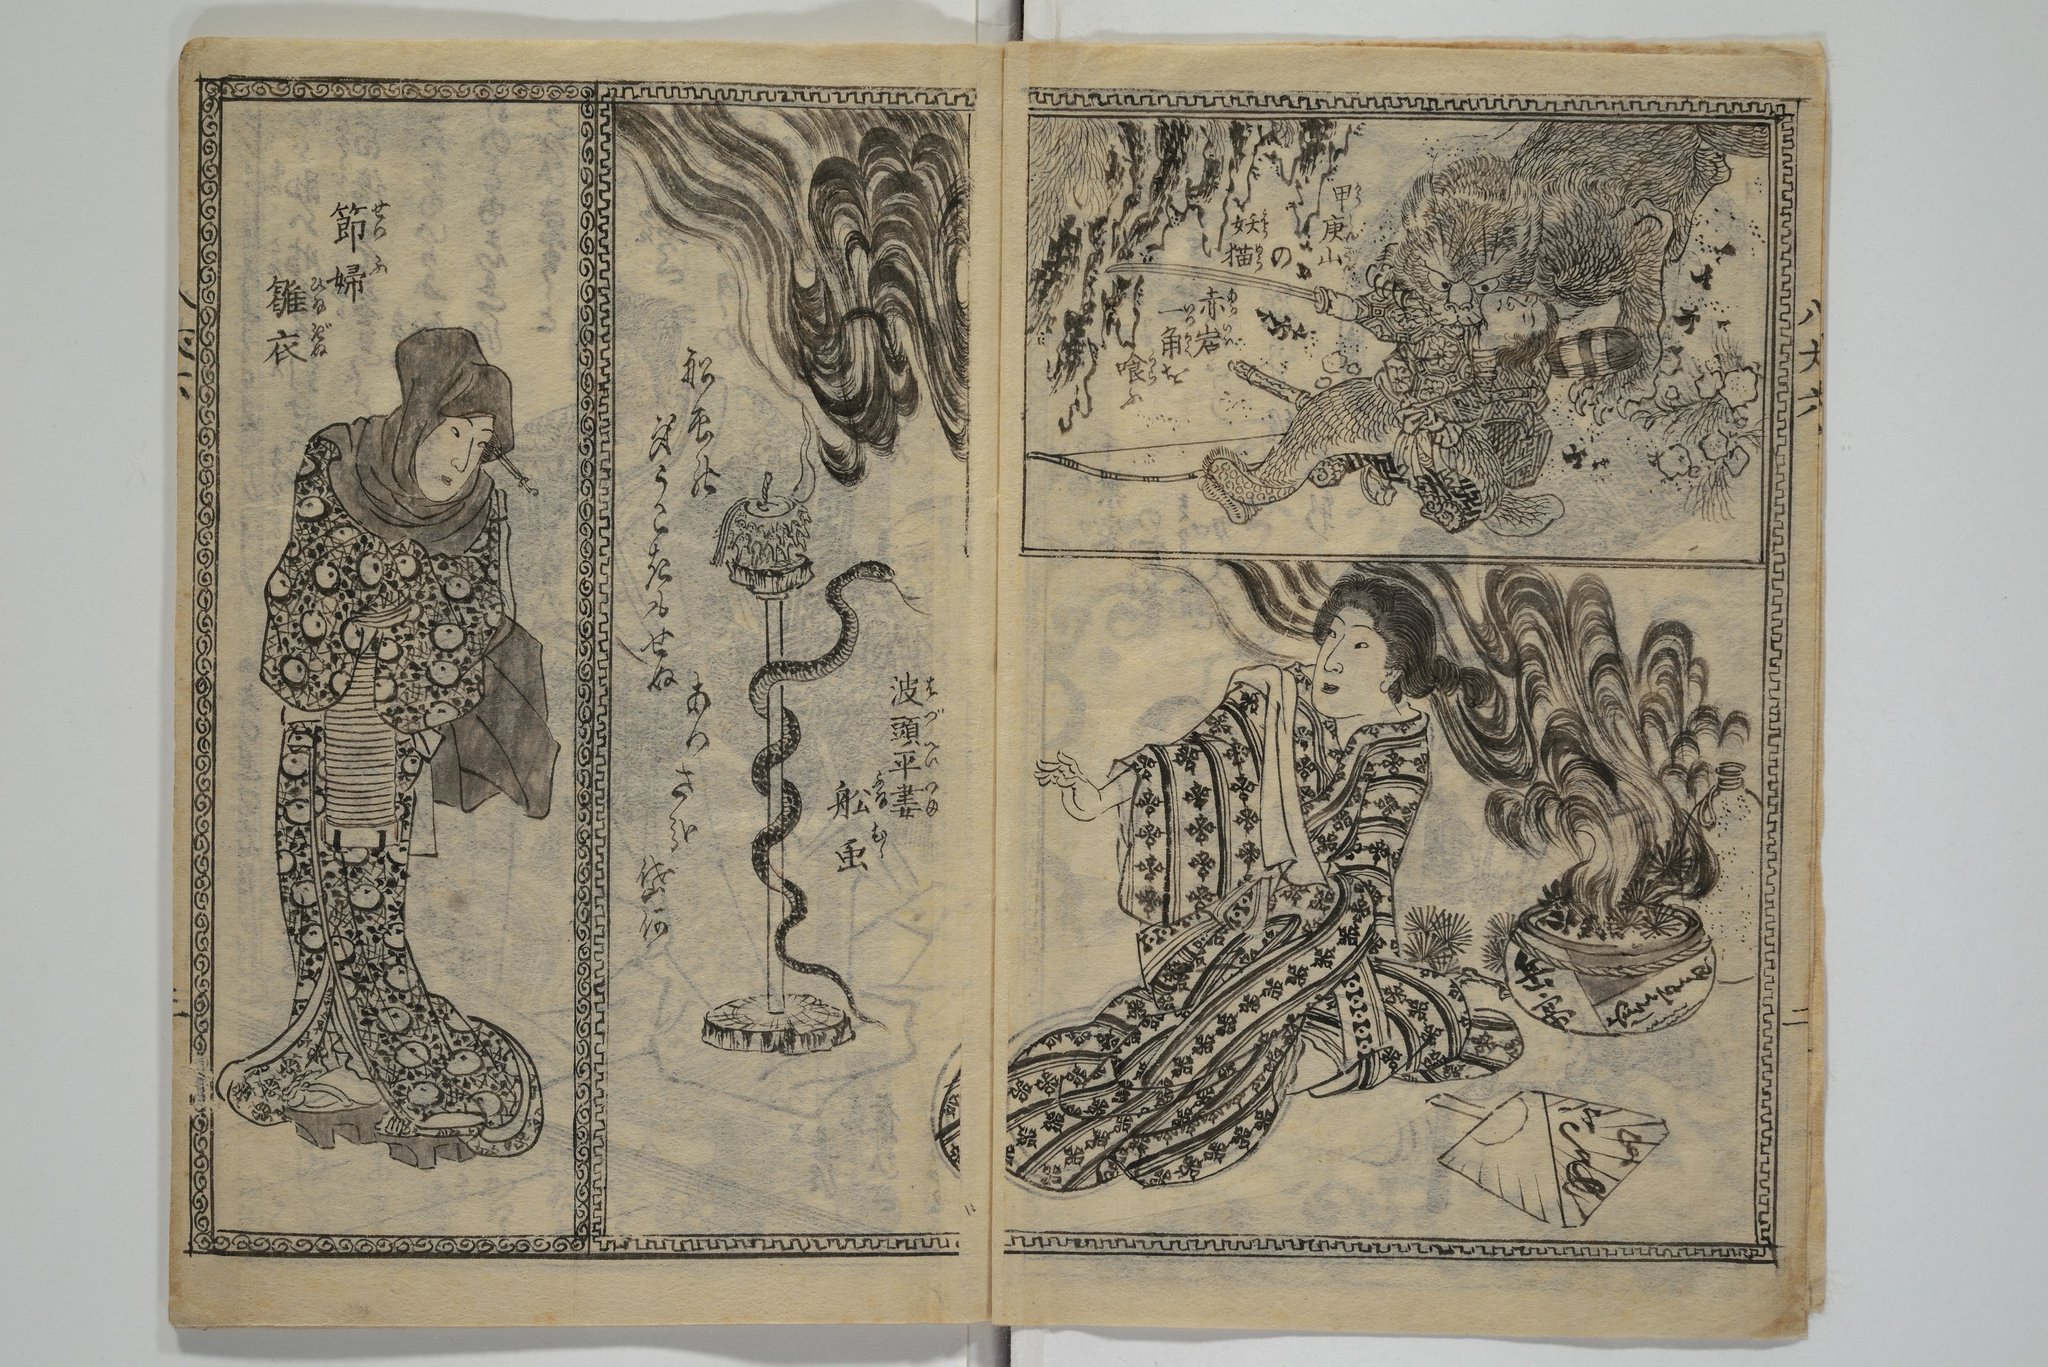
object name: illustrated book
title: Chaps. 4, 5 of Legends of the Dog Warriors (Hakkenden) 八犬伝；版下絵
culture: japanese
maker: utagawa yoshimune 歌川 芳宗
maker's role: artist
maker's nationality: japanese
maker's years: 1817-1880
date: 1860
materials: ink, paper